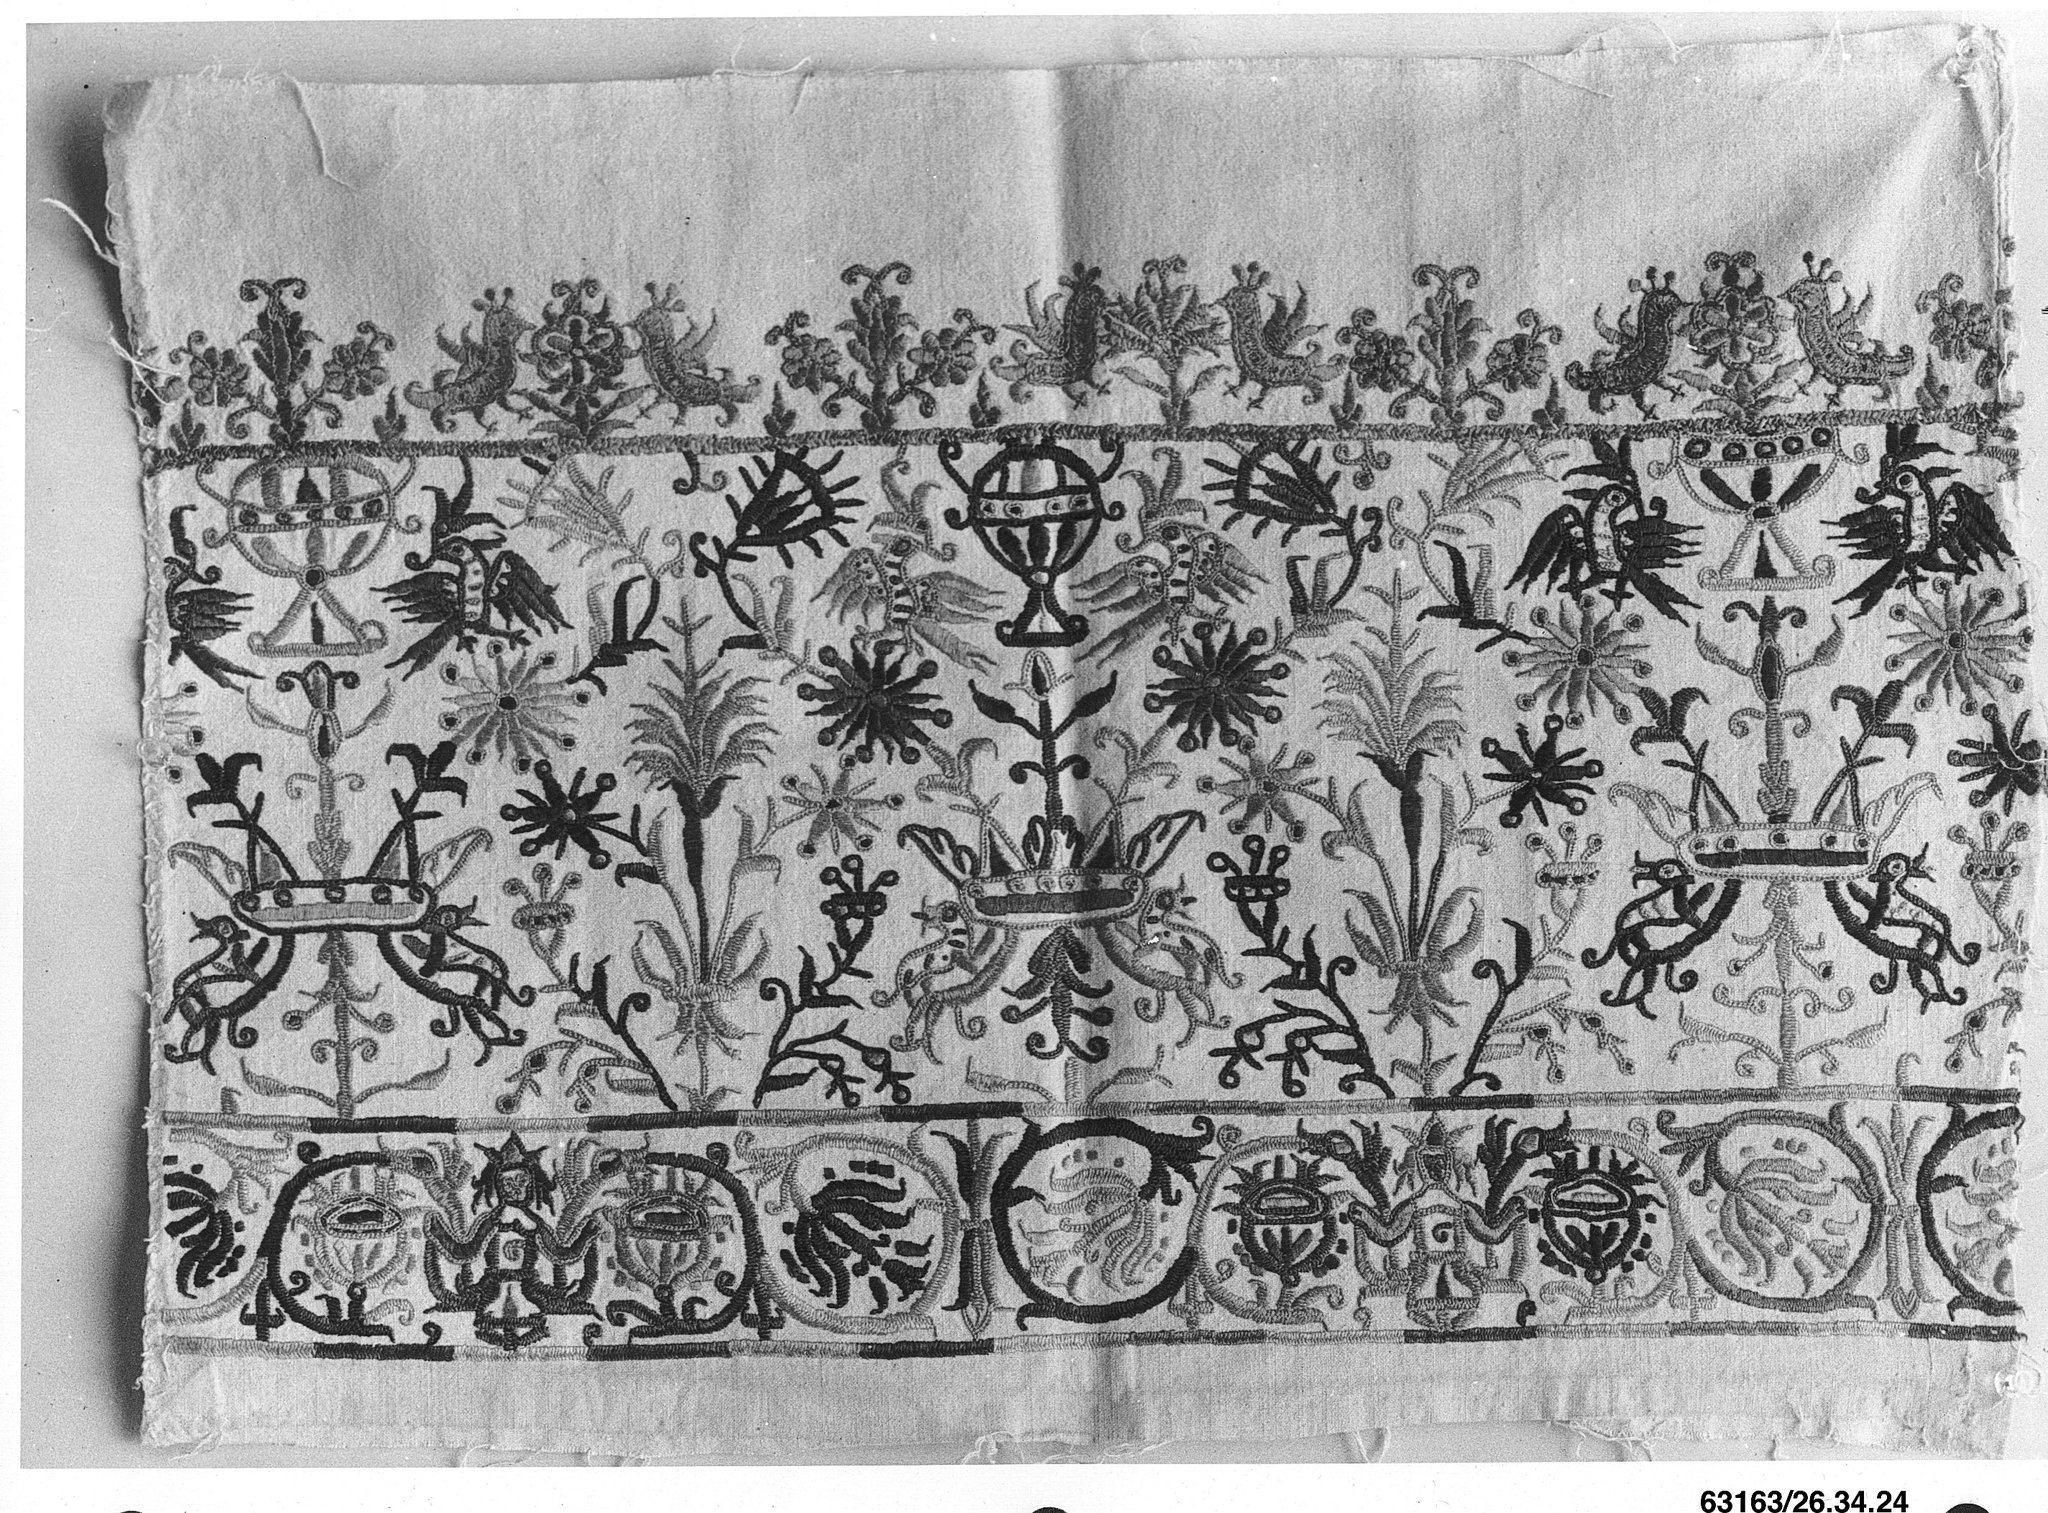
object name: border fragment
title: Portion of a dress border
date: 1601-1800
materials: linen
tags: birds,flowers